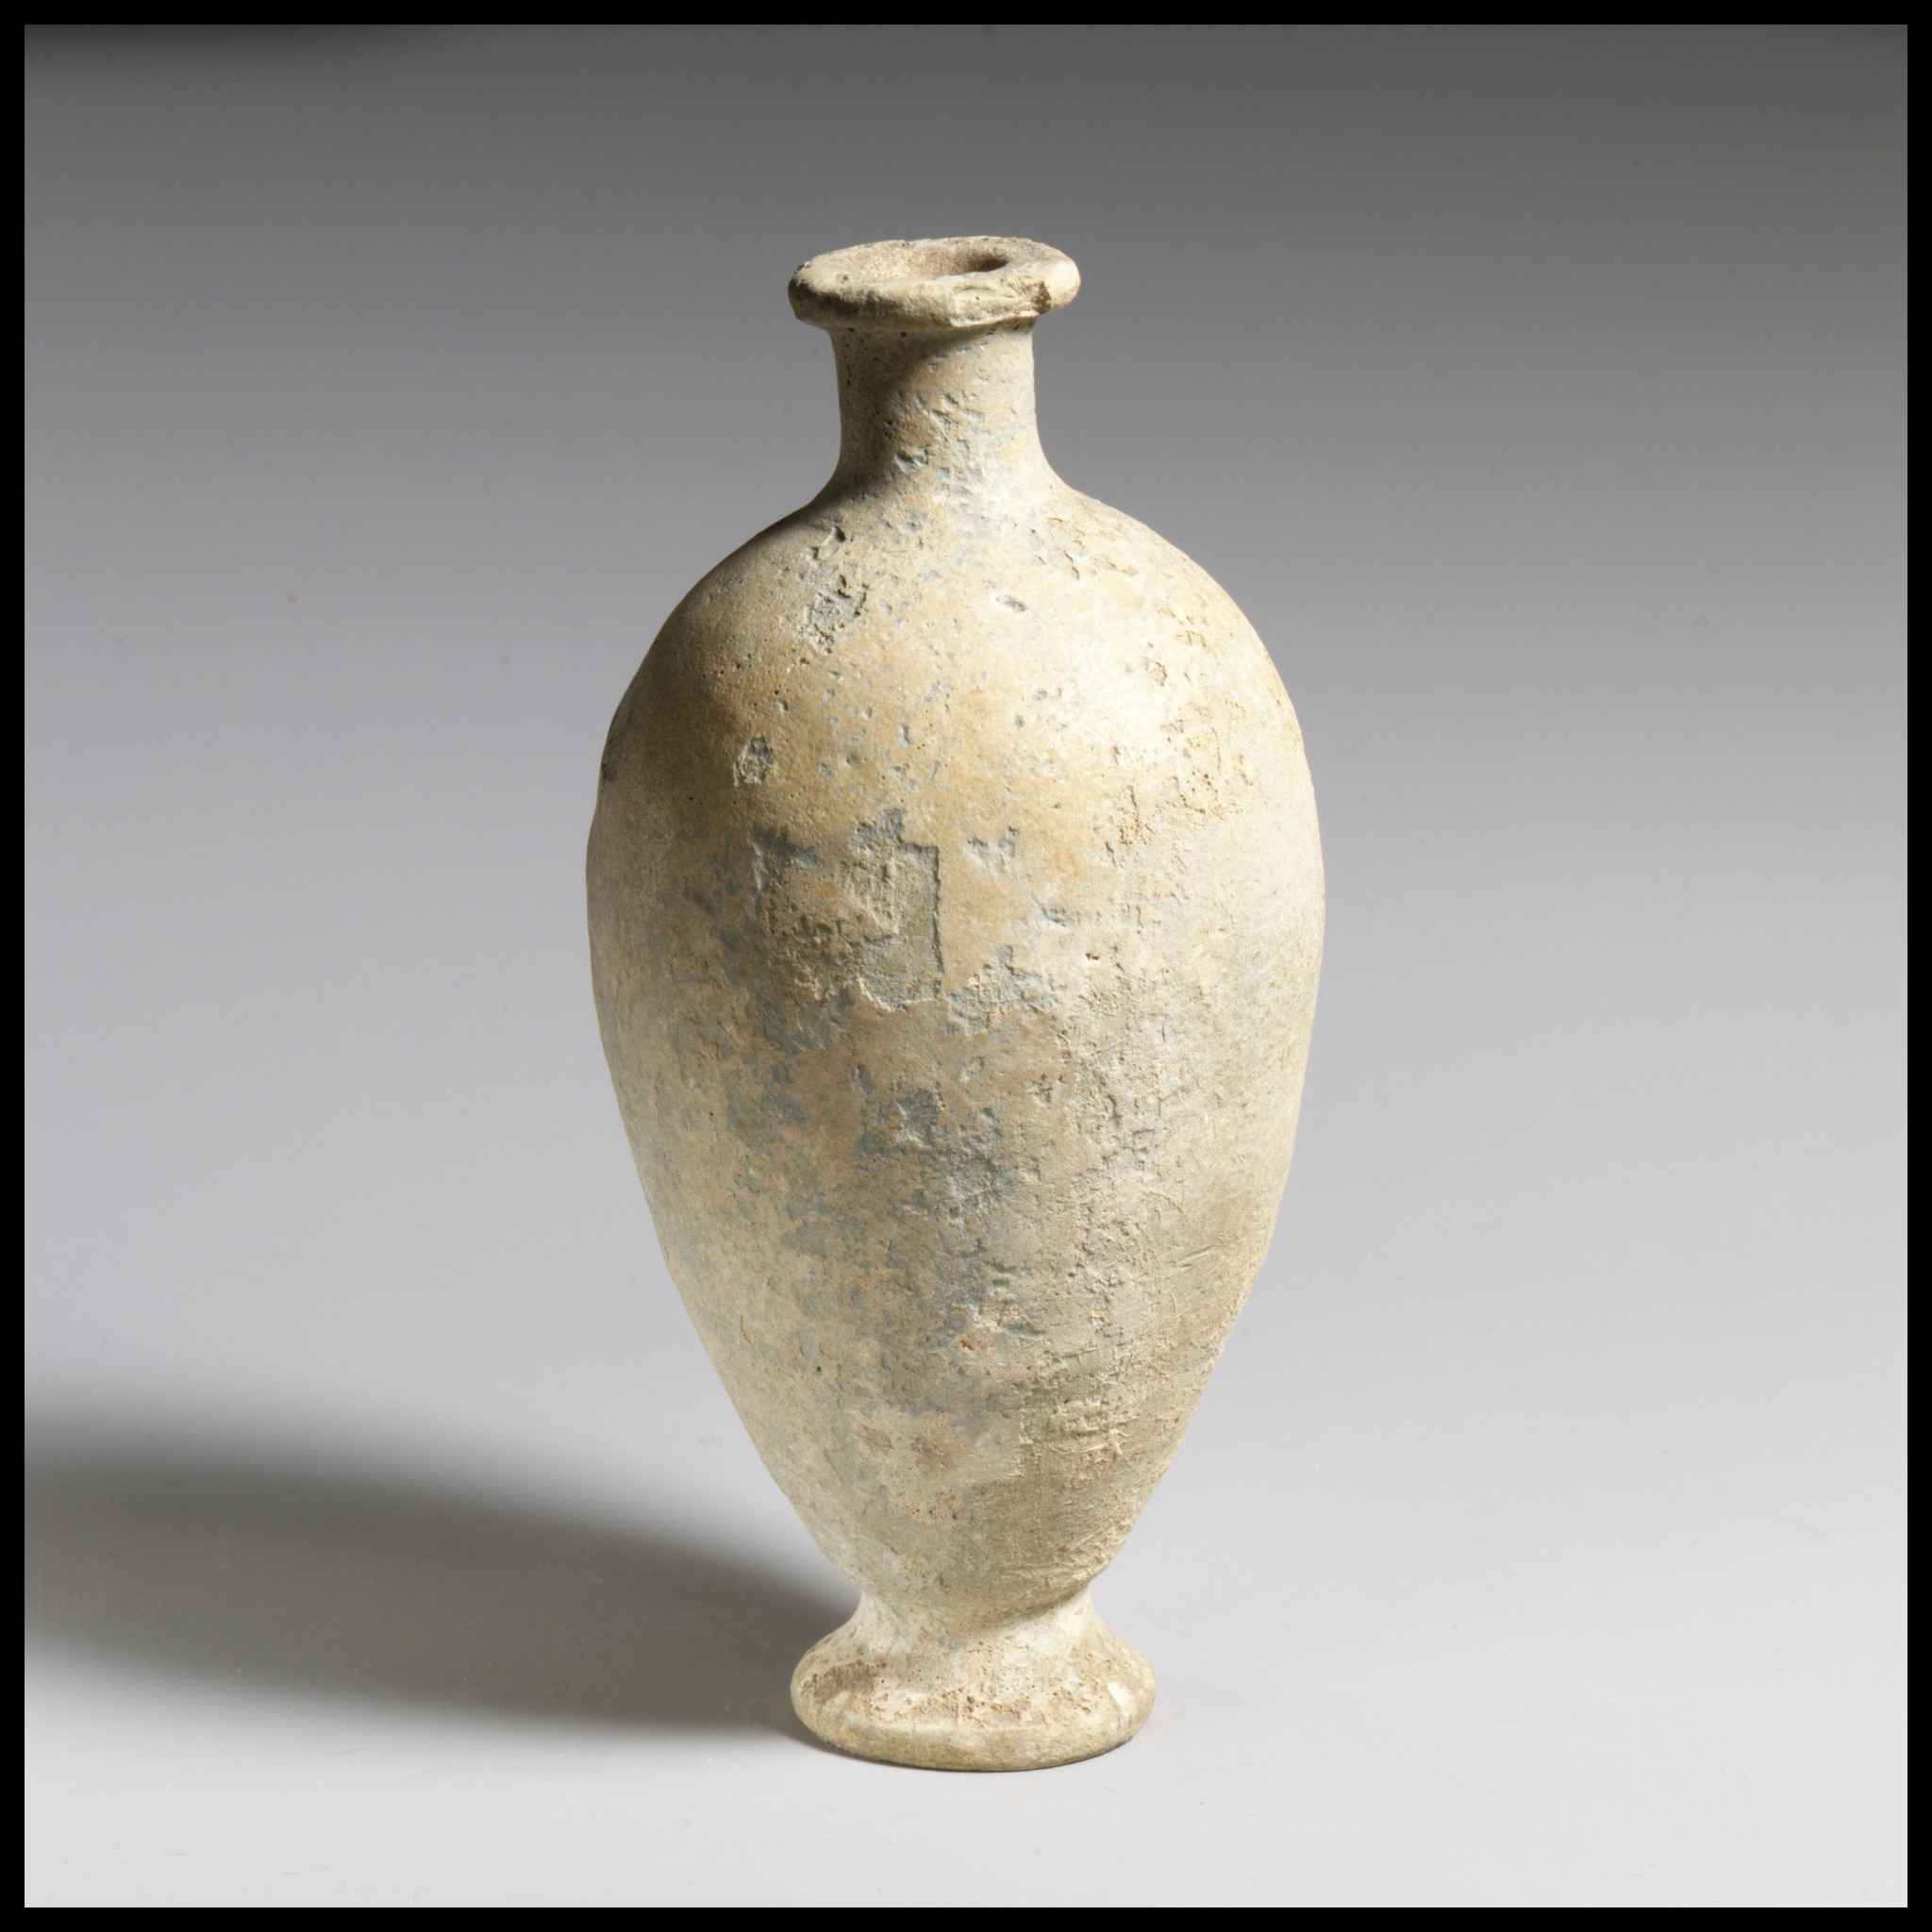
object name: bottle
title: Clay bottle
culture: cypriot or levantine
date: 1300-1101 BCE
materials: faience